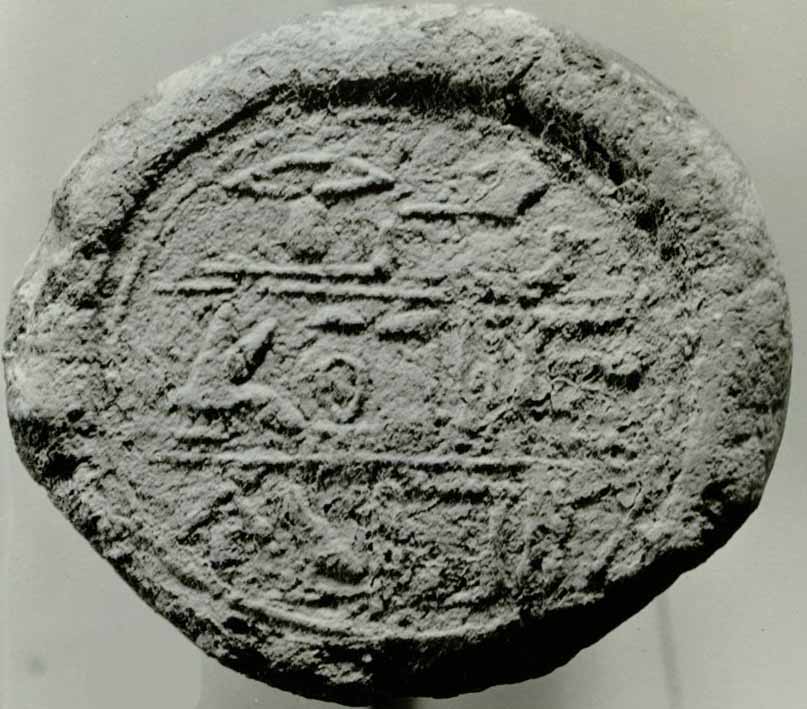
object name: cone, circular impression, iaiefib, seal bearer, priest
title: Funerary Cone of the High Priest of Amun Hapuseneb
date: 1479-1458 BCE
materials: pottery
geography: egypt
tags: hieroglyphs